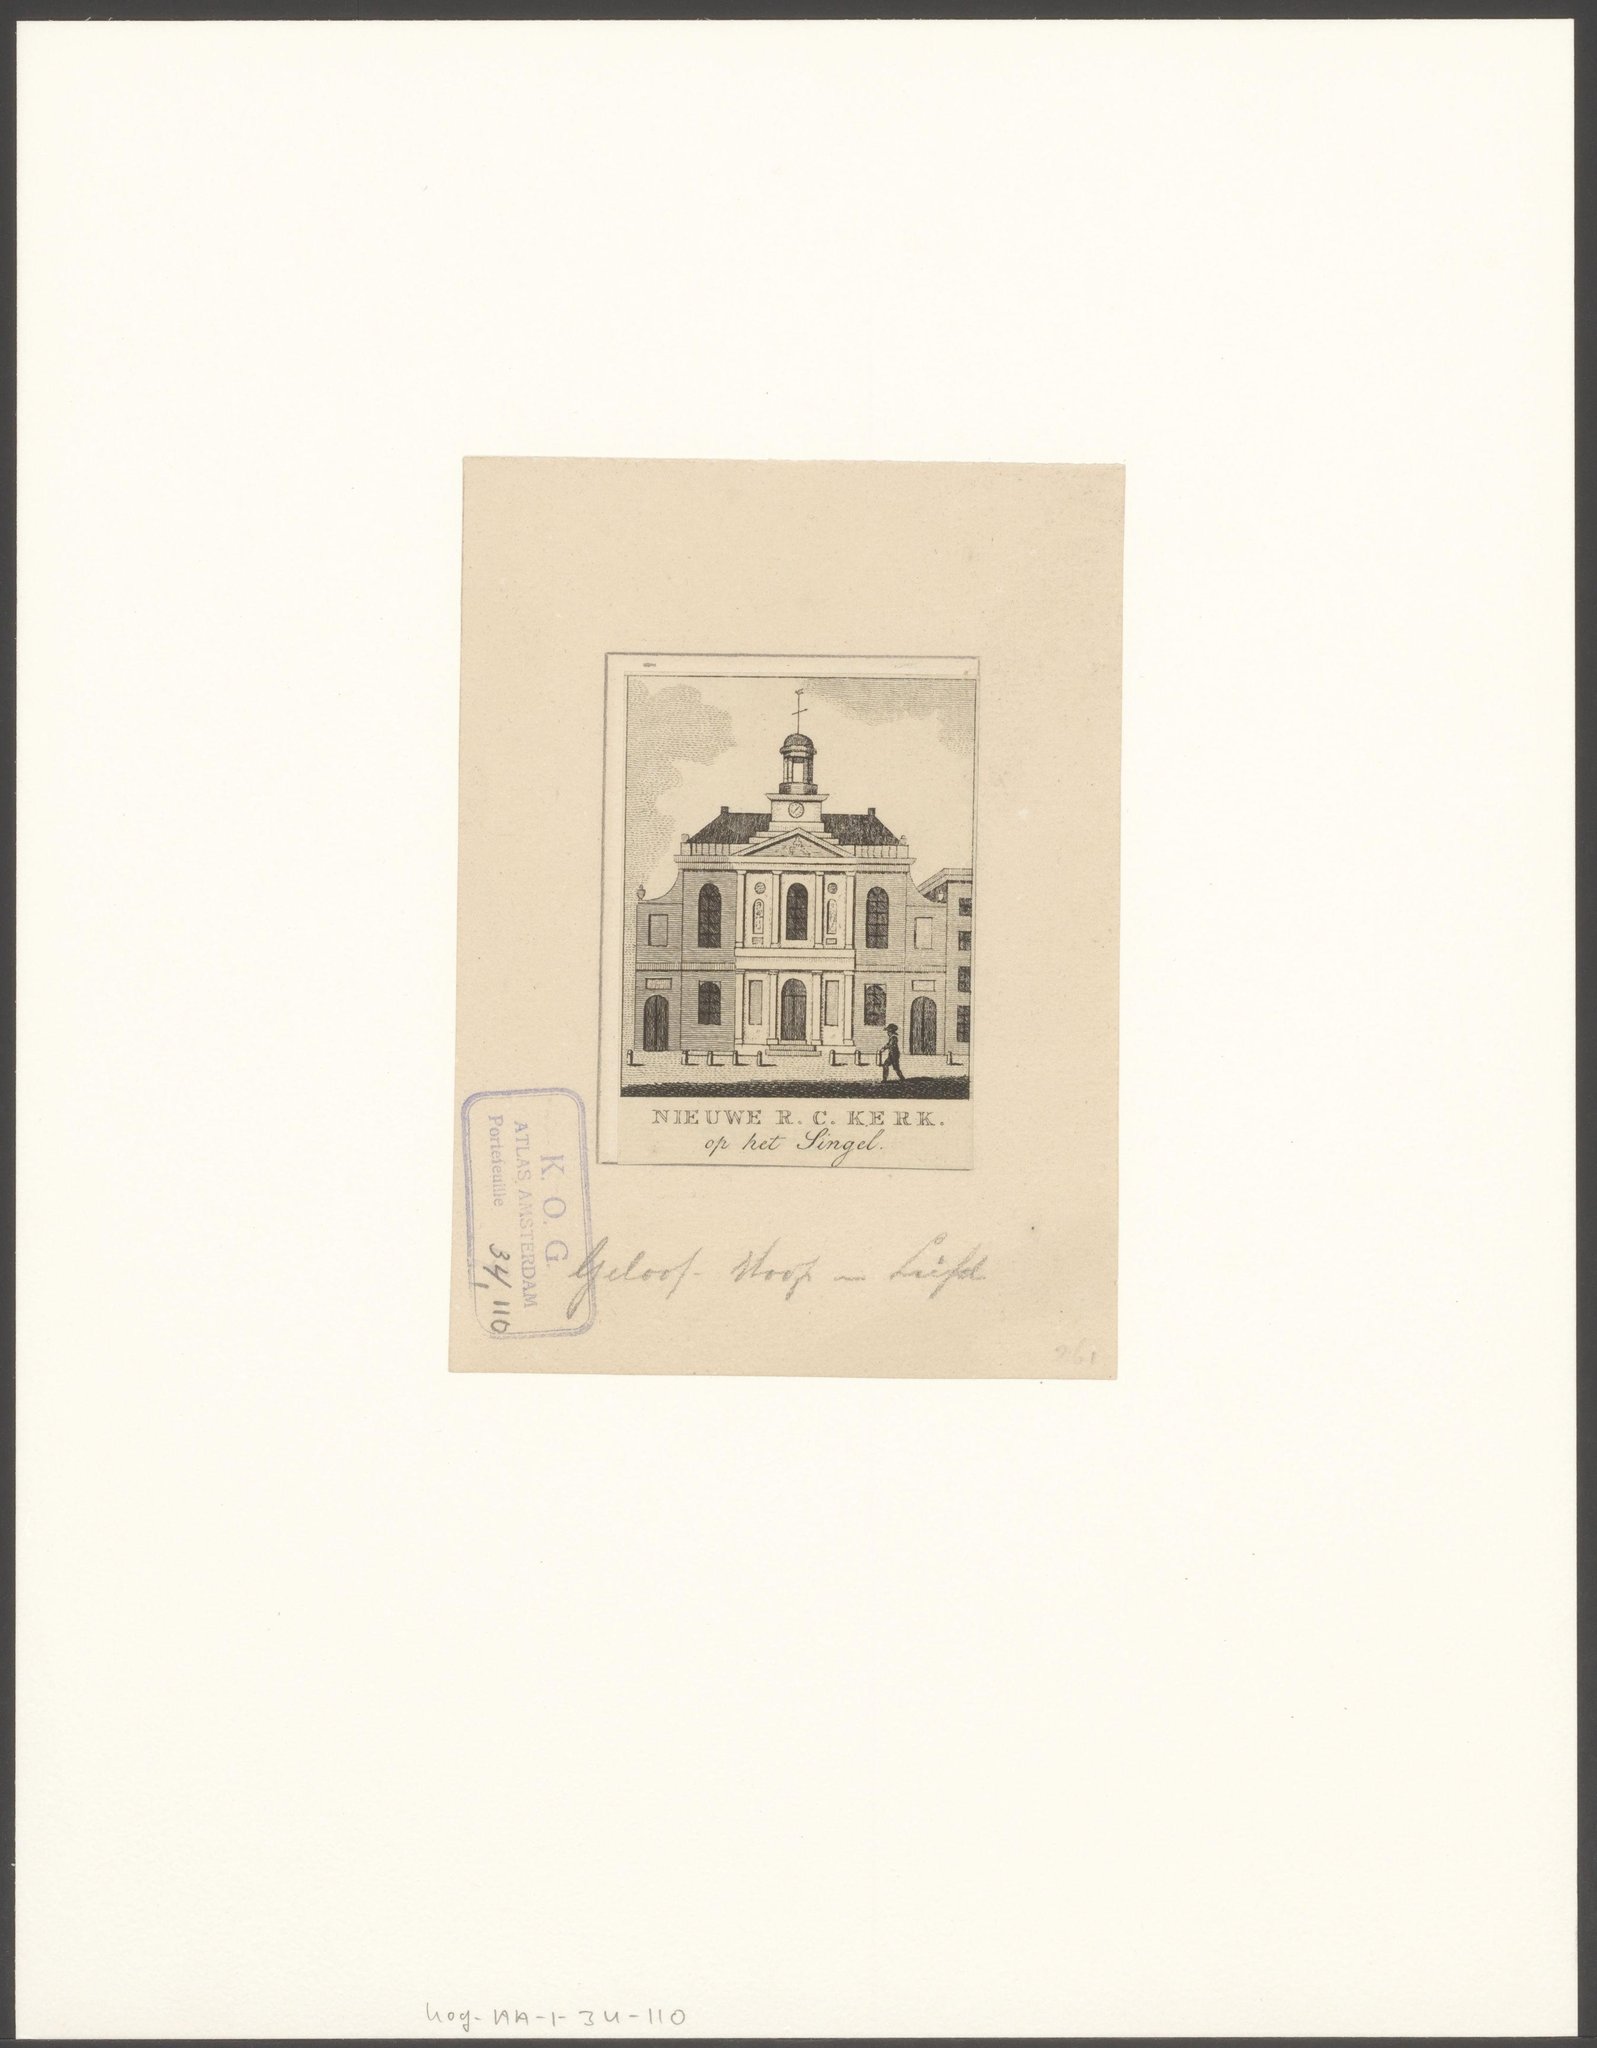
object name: print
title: Gezicht op de Sint-Catharinakerk te Amsterdam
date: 1826-1847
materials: paper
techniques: engraving, etching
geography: netherlands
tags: church (exterior), street (+ city(-scape) with figures, staffage)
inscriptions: collector's mark: Lugt 1641b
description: Onderwerpsrubriek binnen de Atlas Amsterdam: Kerkwezen: R.K. Gemeenten: Begijnhof t/m Petrus en Paulus.